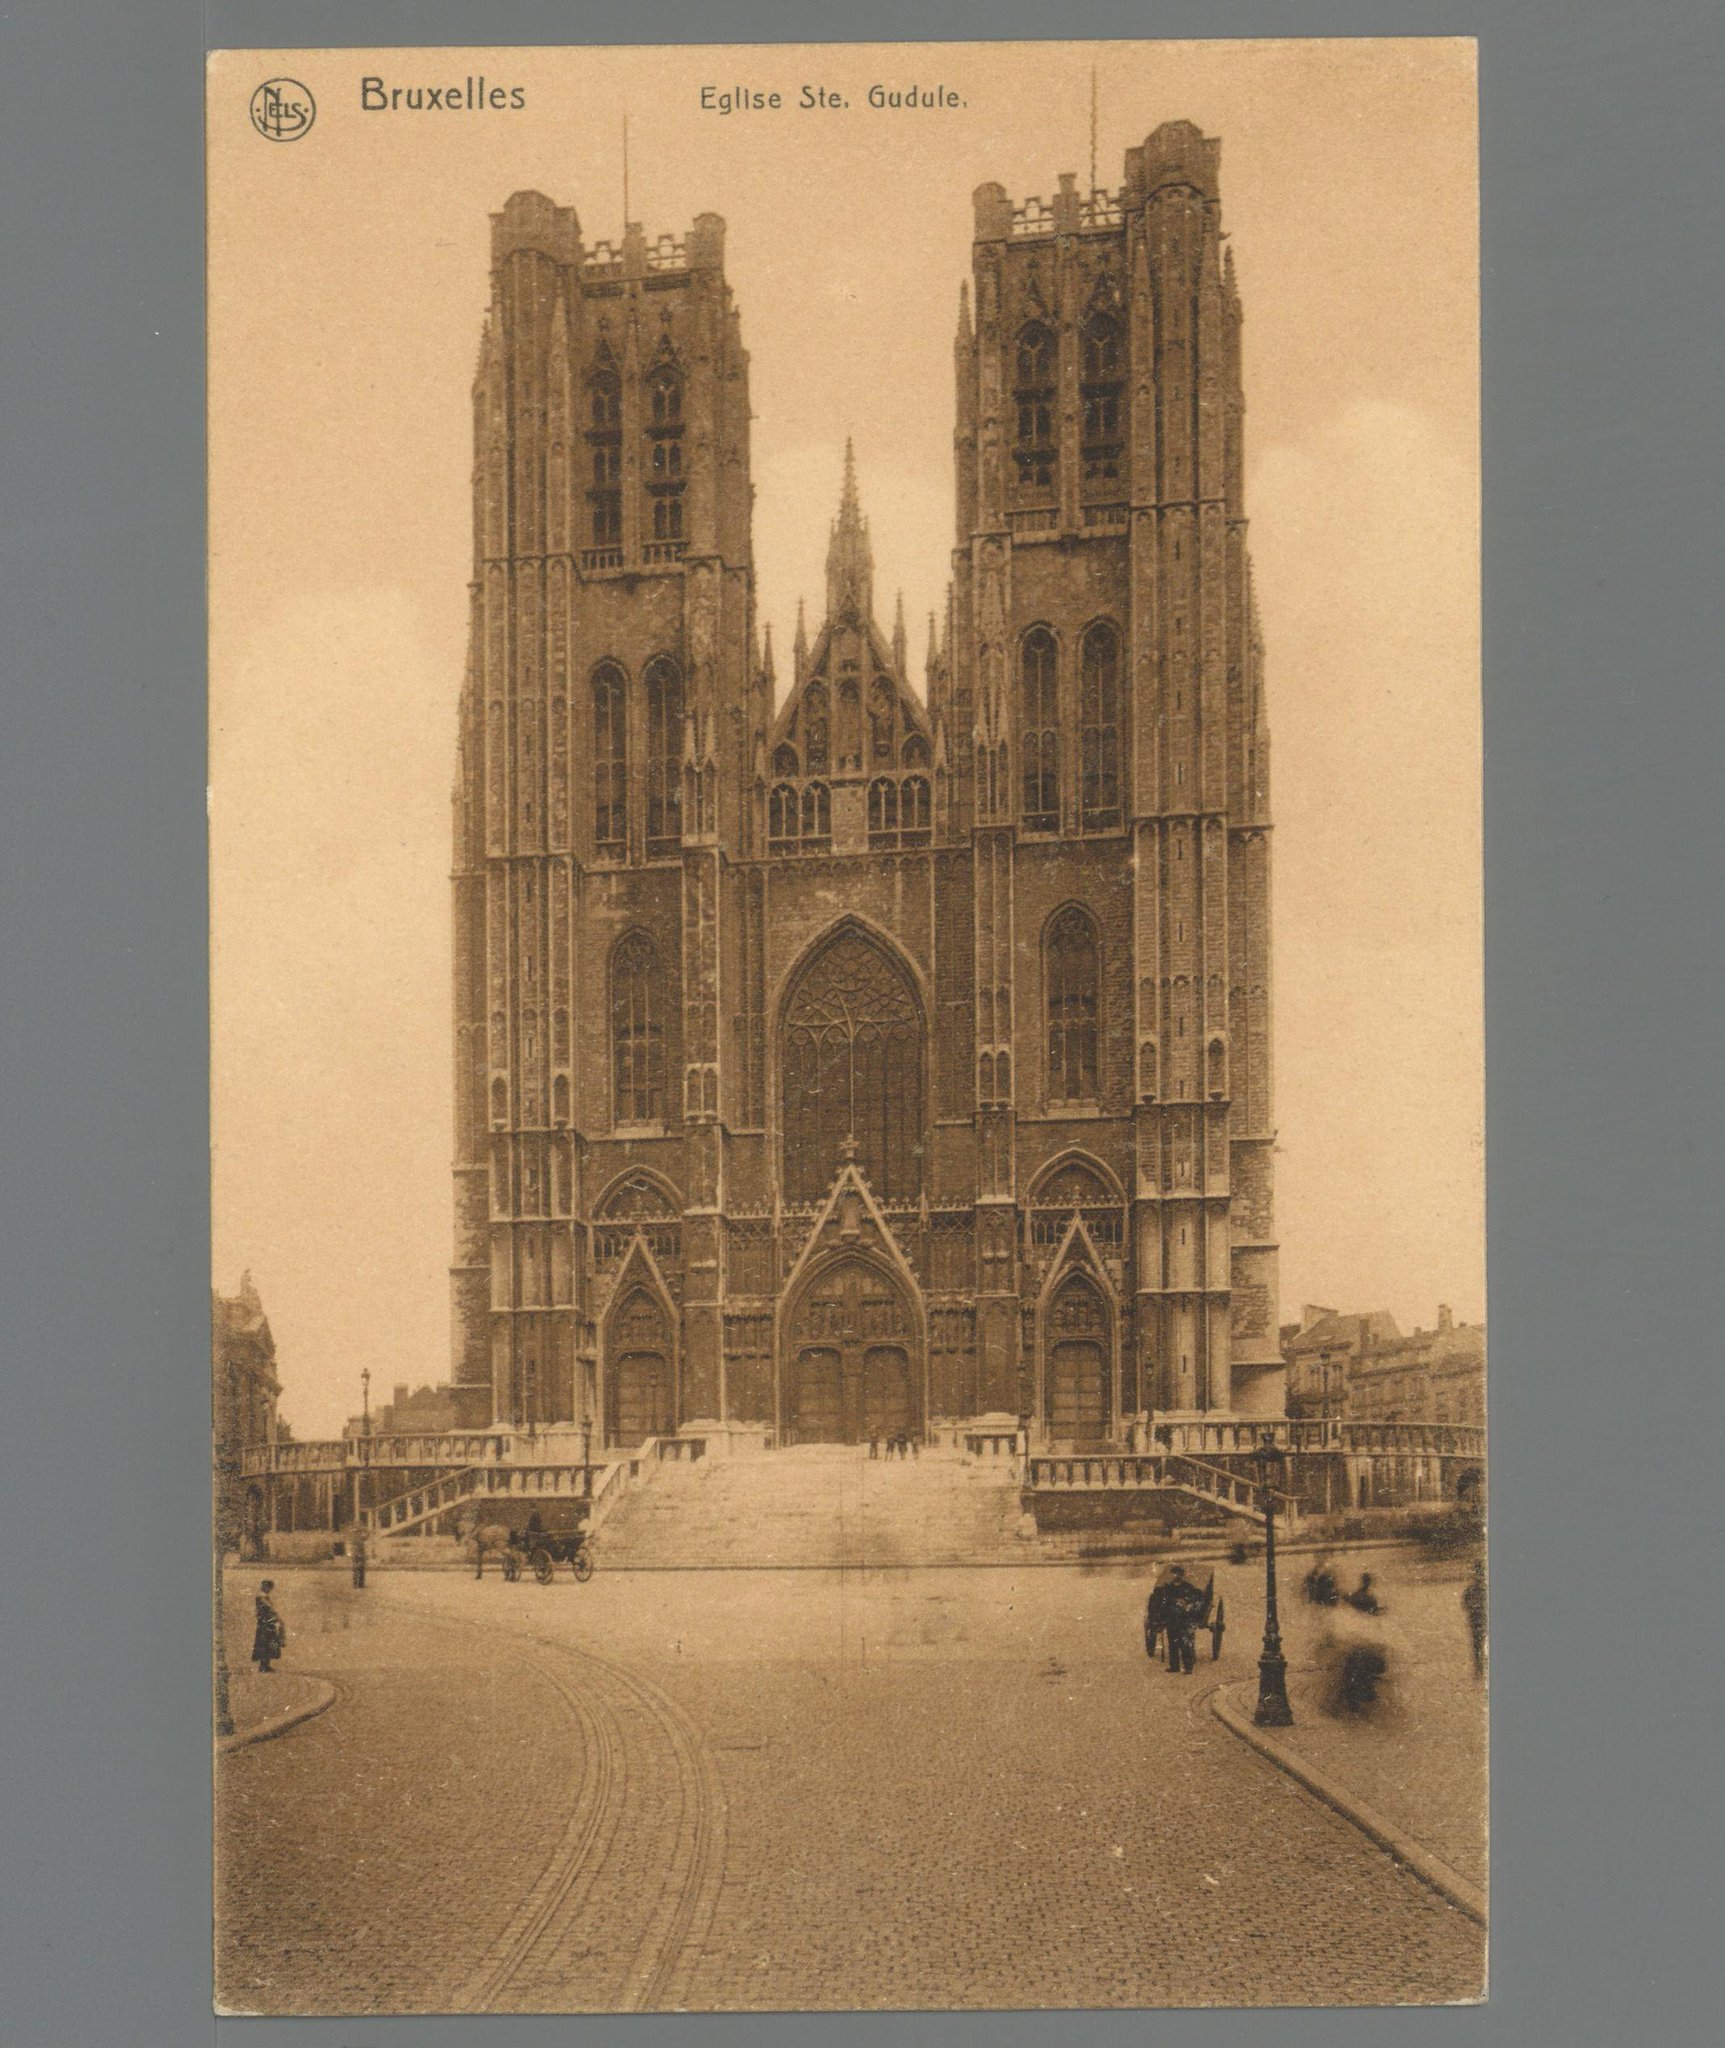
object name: ansichtkaart, prentbriefkaart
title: Serie Bruxelles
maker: Anonymous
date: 1907-1913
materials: cardboard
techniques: photograph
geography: brussels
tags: church (exterior), city-view, and landscape with man-made constructions (+ city(-scape) with figures, staffage)